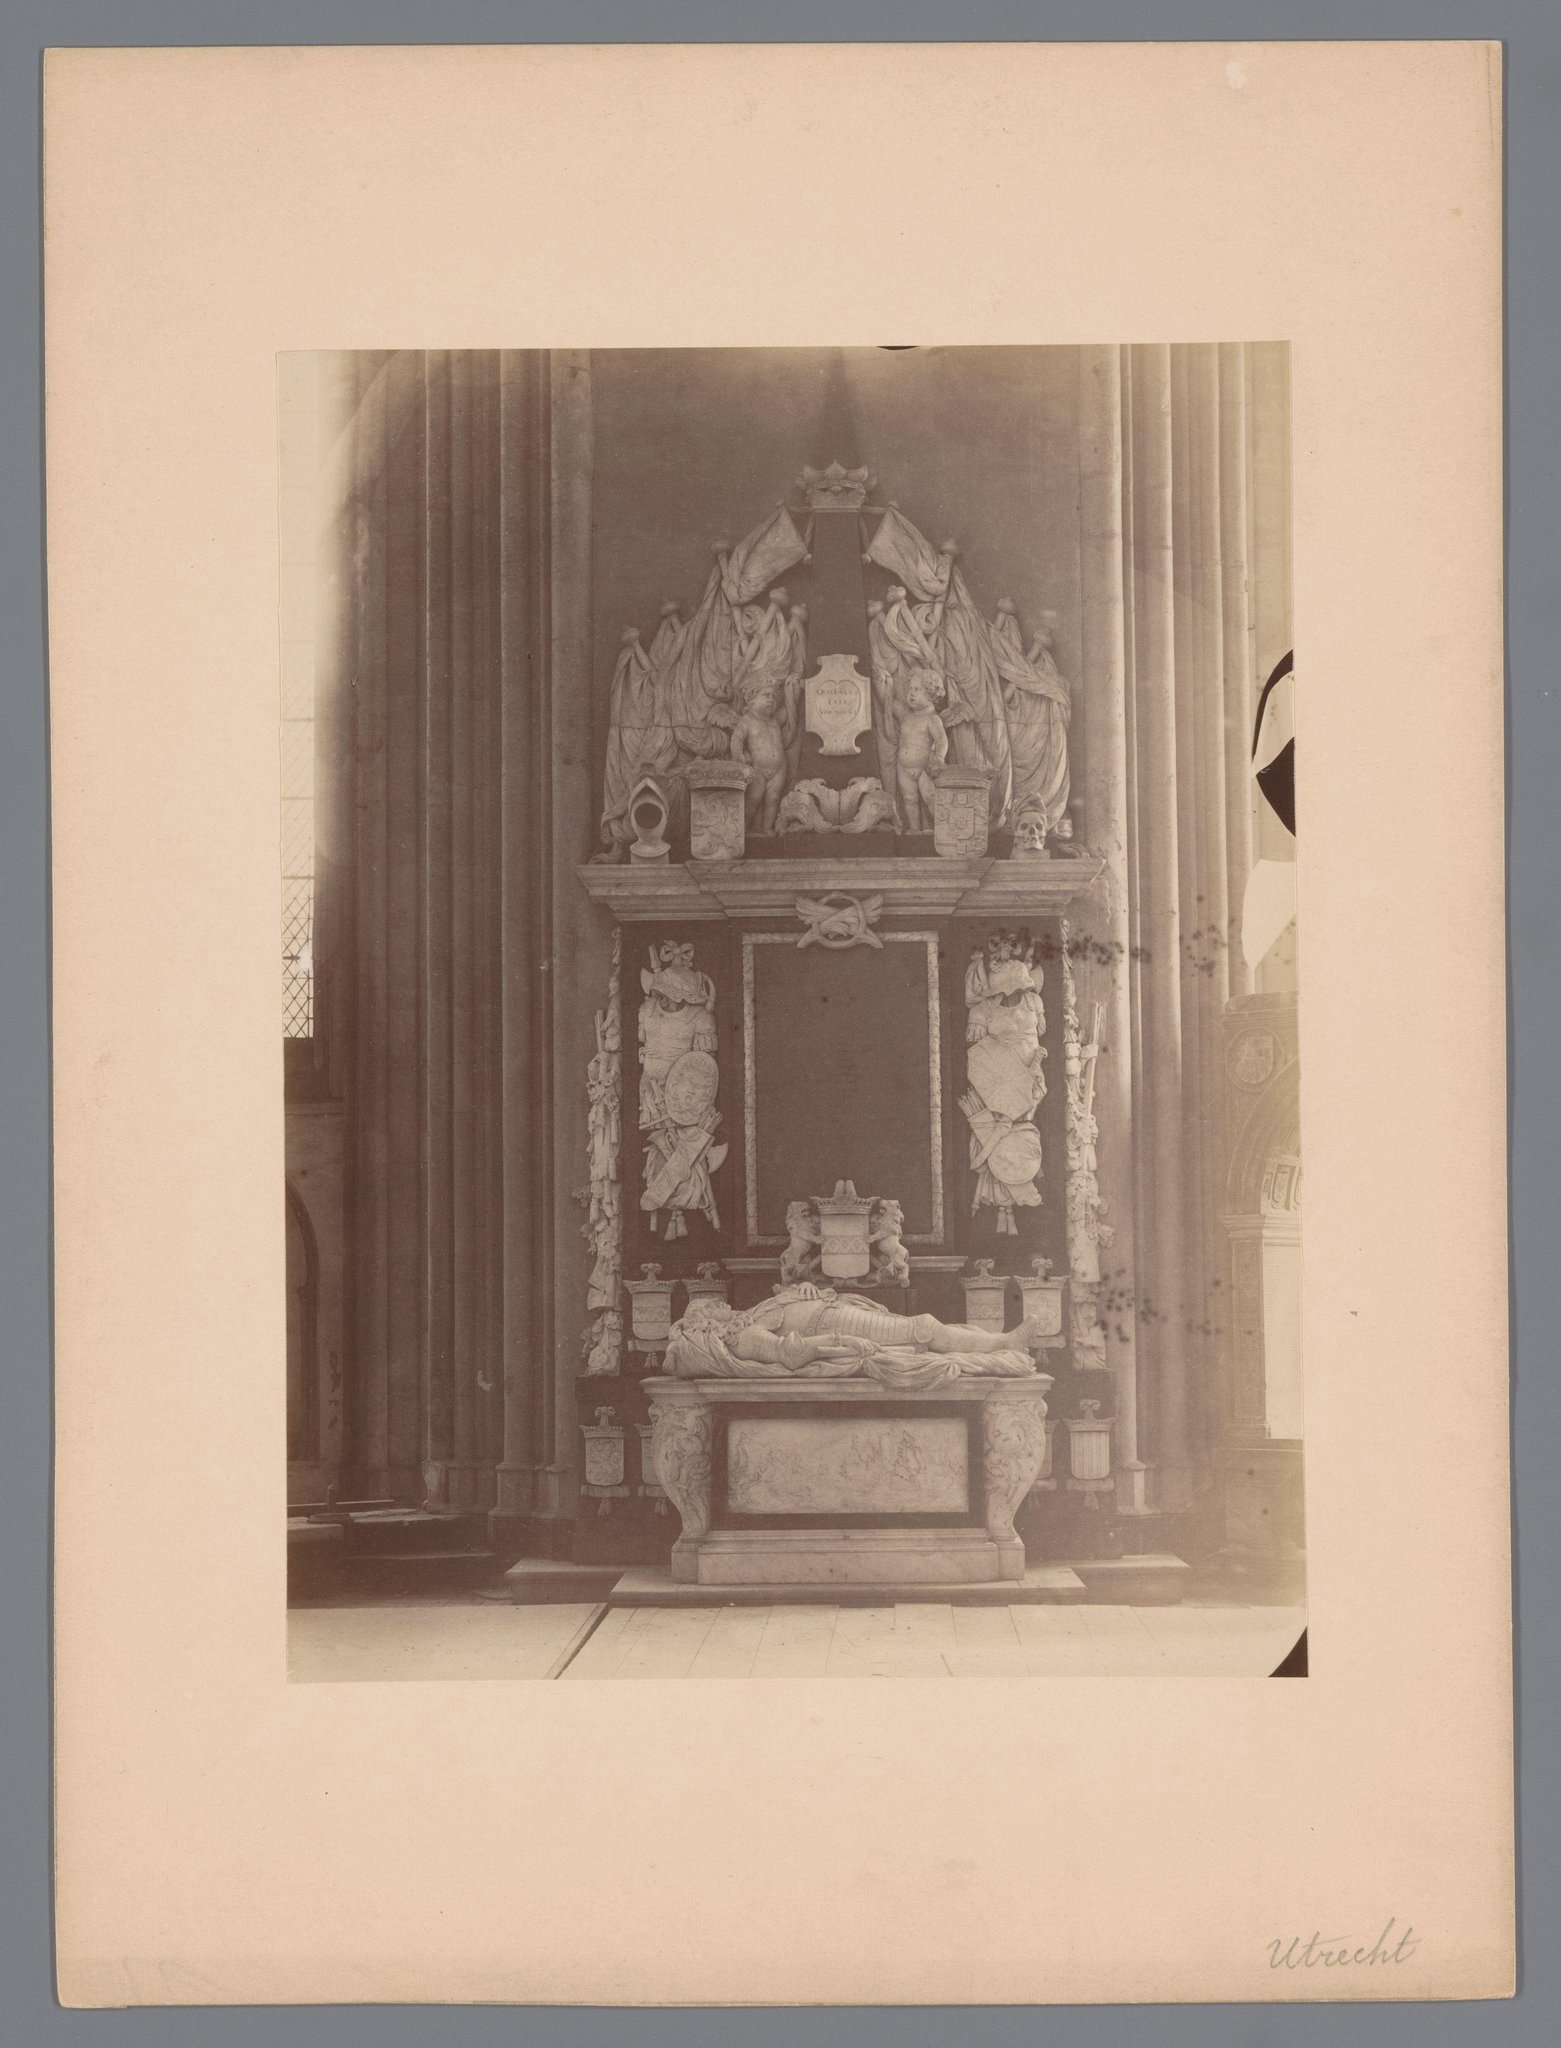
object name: photograph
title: Grafmonument van Willem Joseph baron van Gendt in de Dom van Utrecht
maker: anoniem (monumentenzorg)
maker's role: fotograaf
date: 1891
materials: cardboard, photographic support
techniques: albumen print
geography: utrecht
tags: willem joseph baron van gendt, interior of church, grave-building, monumental tomb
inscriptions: annotation: ‘Domkerk te Utrecht/ Monument in het koor/ sept 1891’, annotation: ‘Utrecht’